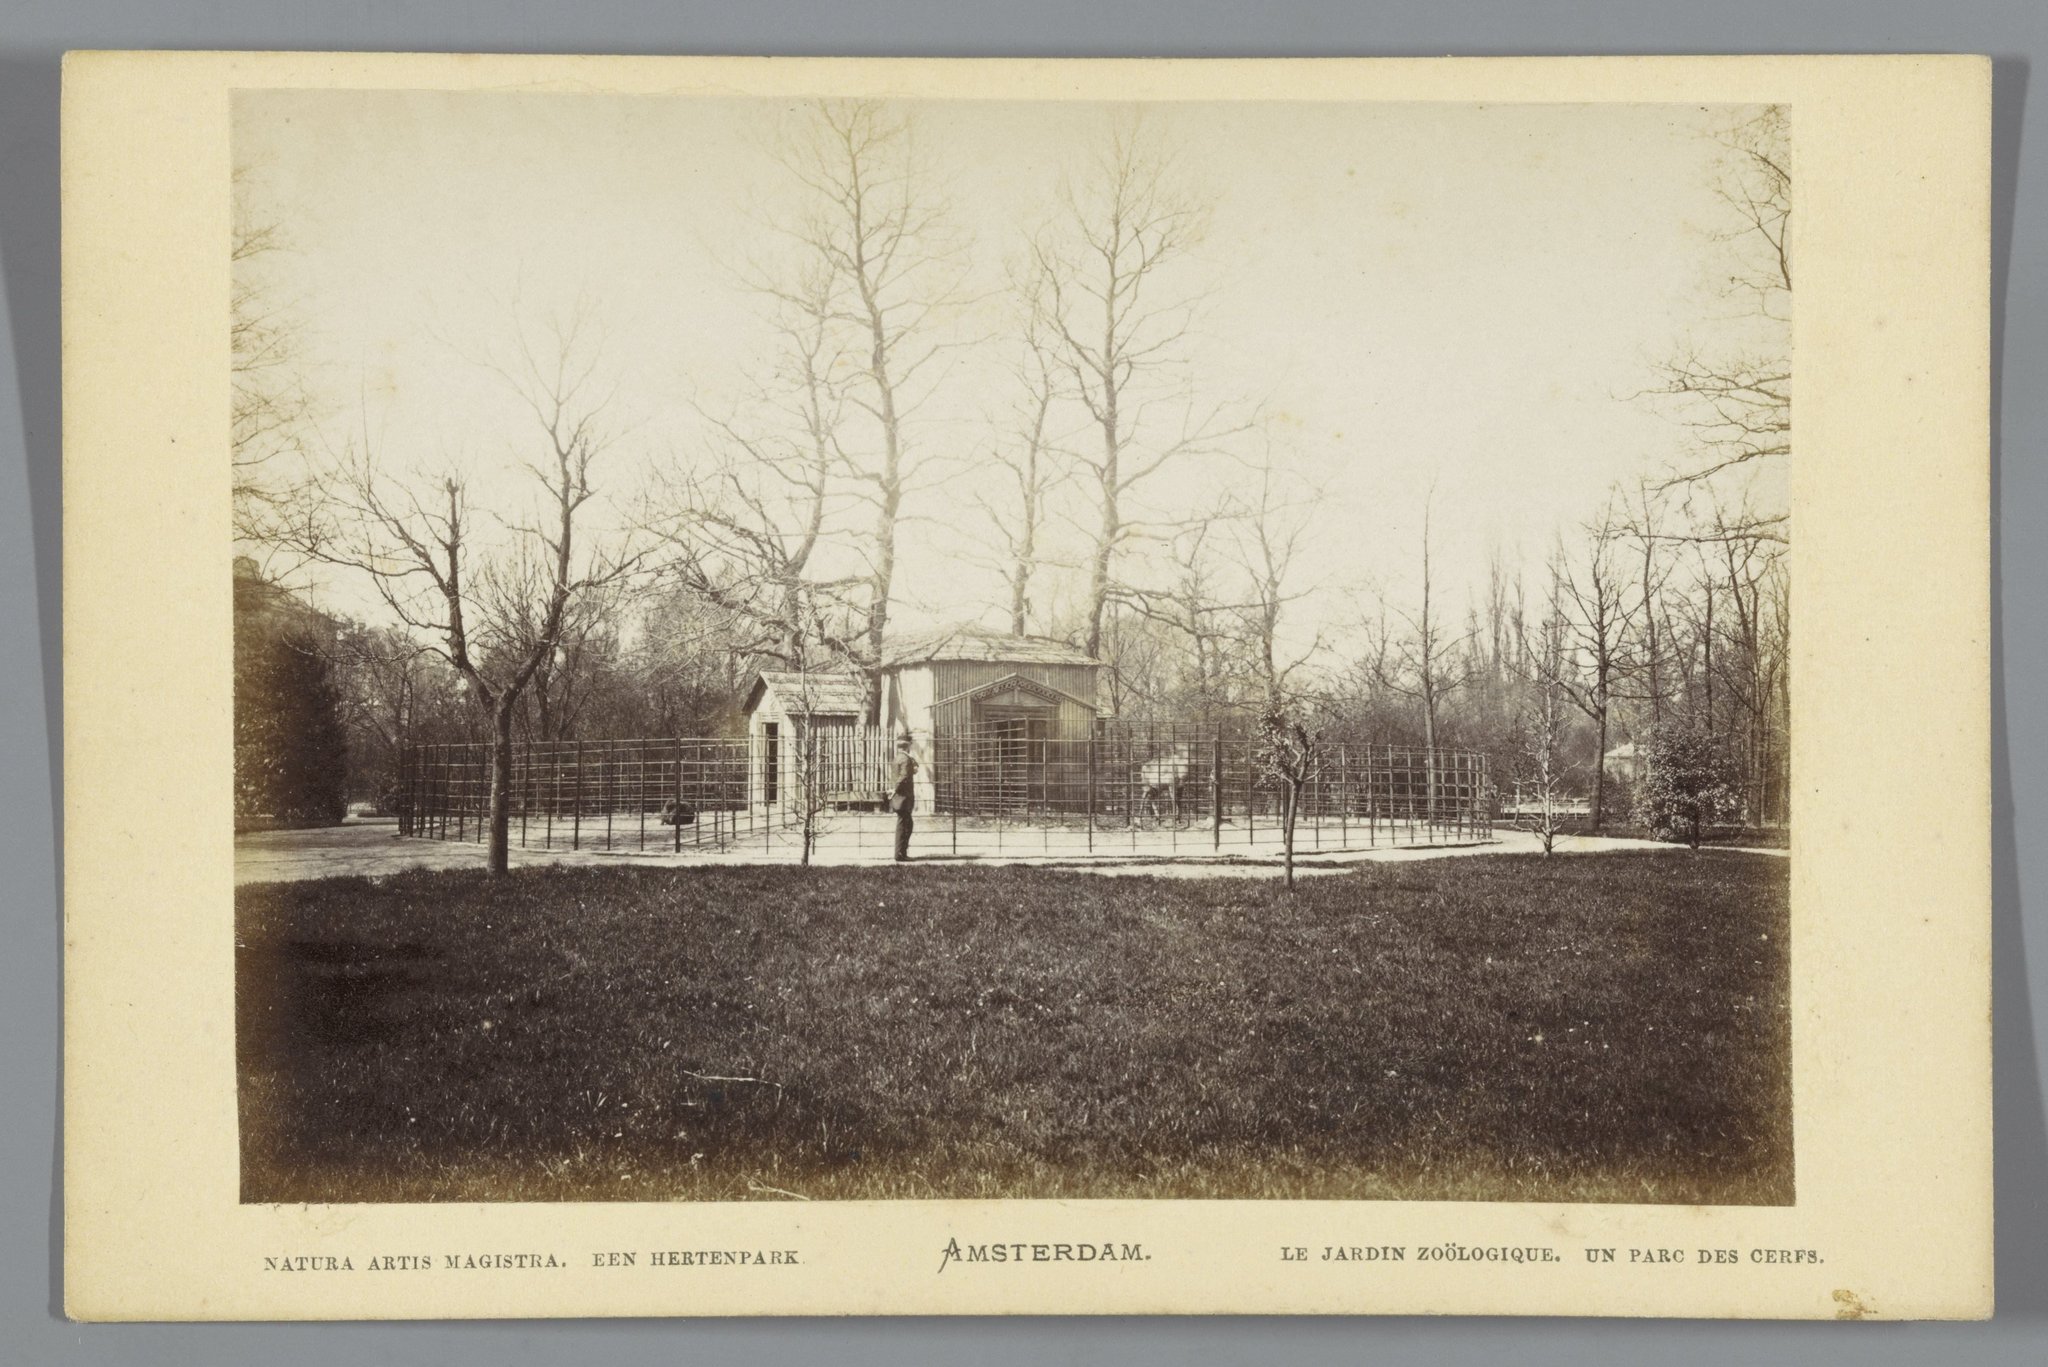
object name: cabinet photograph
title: Natura Artis Magistra. Een hertenpark / Le jardin zoölogique. Un parc des cerfs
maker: andries jager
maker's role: publisher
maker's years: 1825-1905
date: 1860-1890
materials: cardboard, photographic support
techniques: albumen print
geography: amsterdam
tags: hoofed animals: deer, zoological garden, zoo, seen as place where non-domestic animals are kept (+ accomodations for animals)